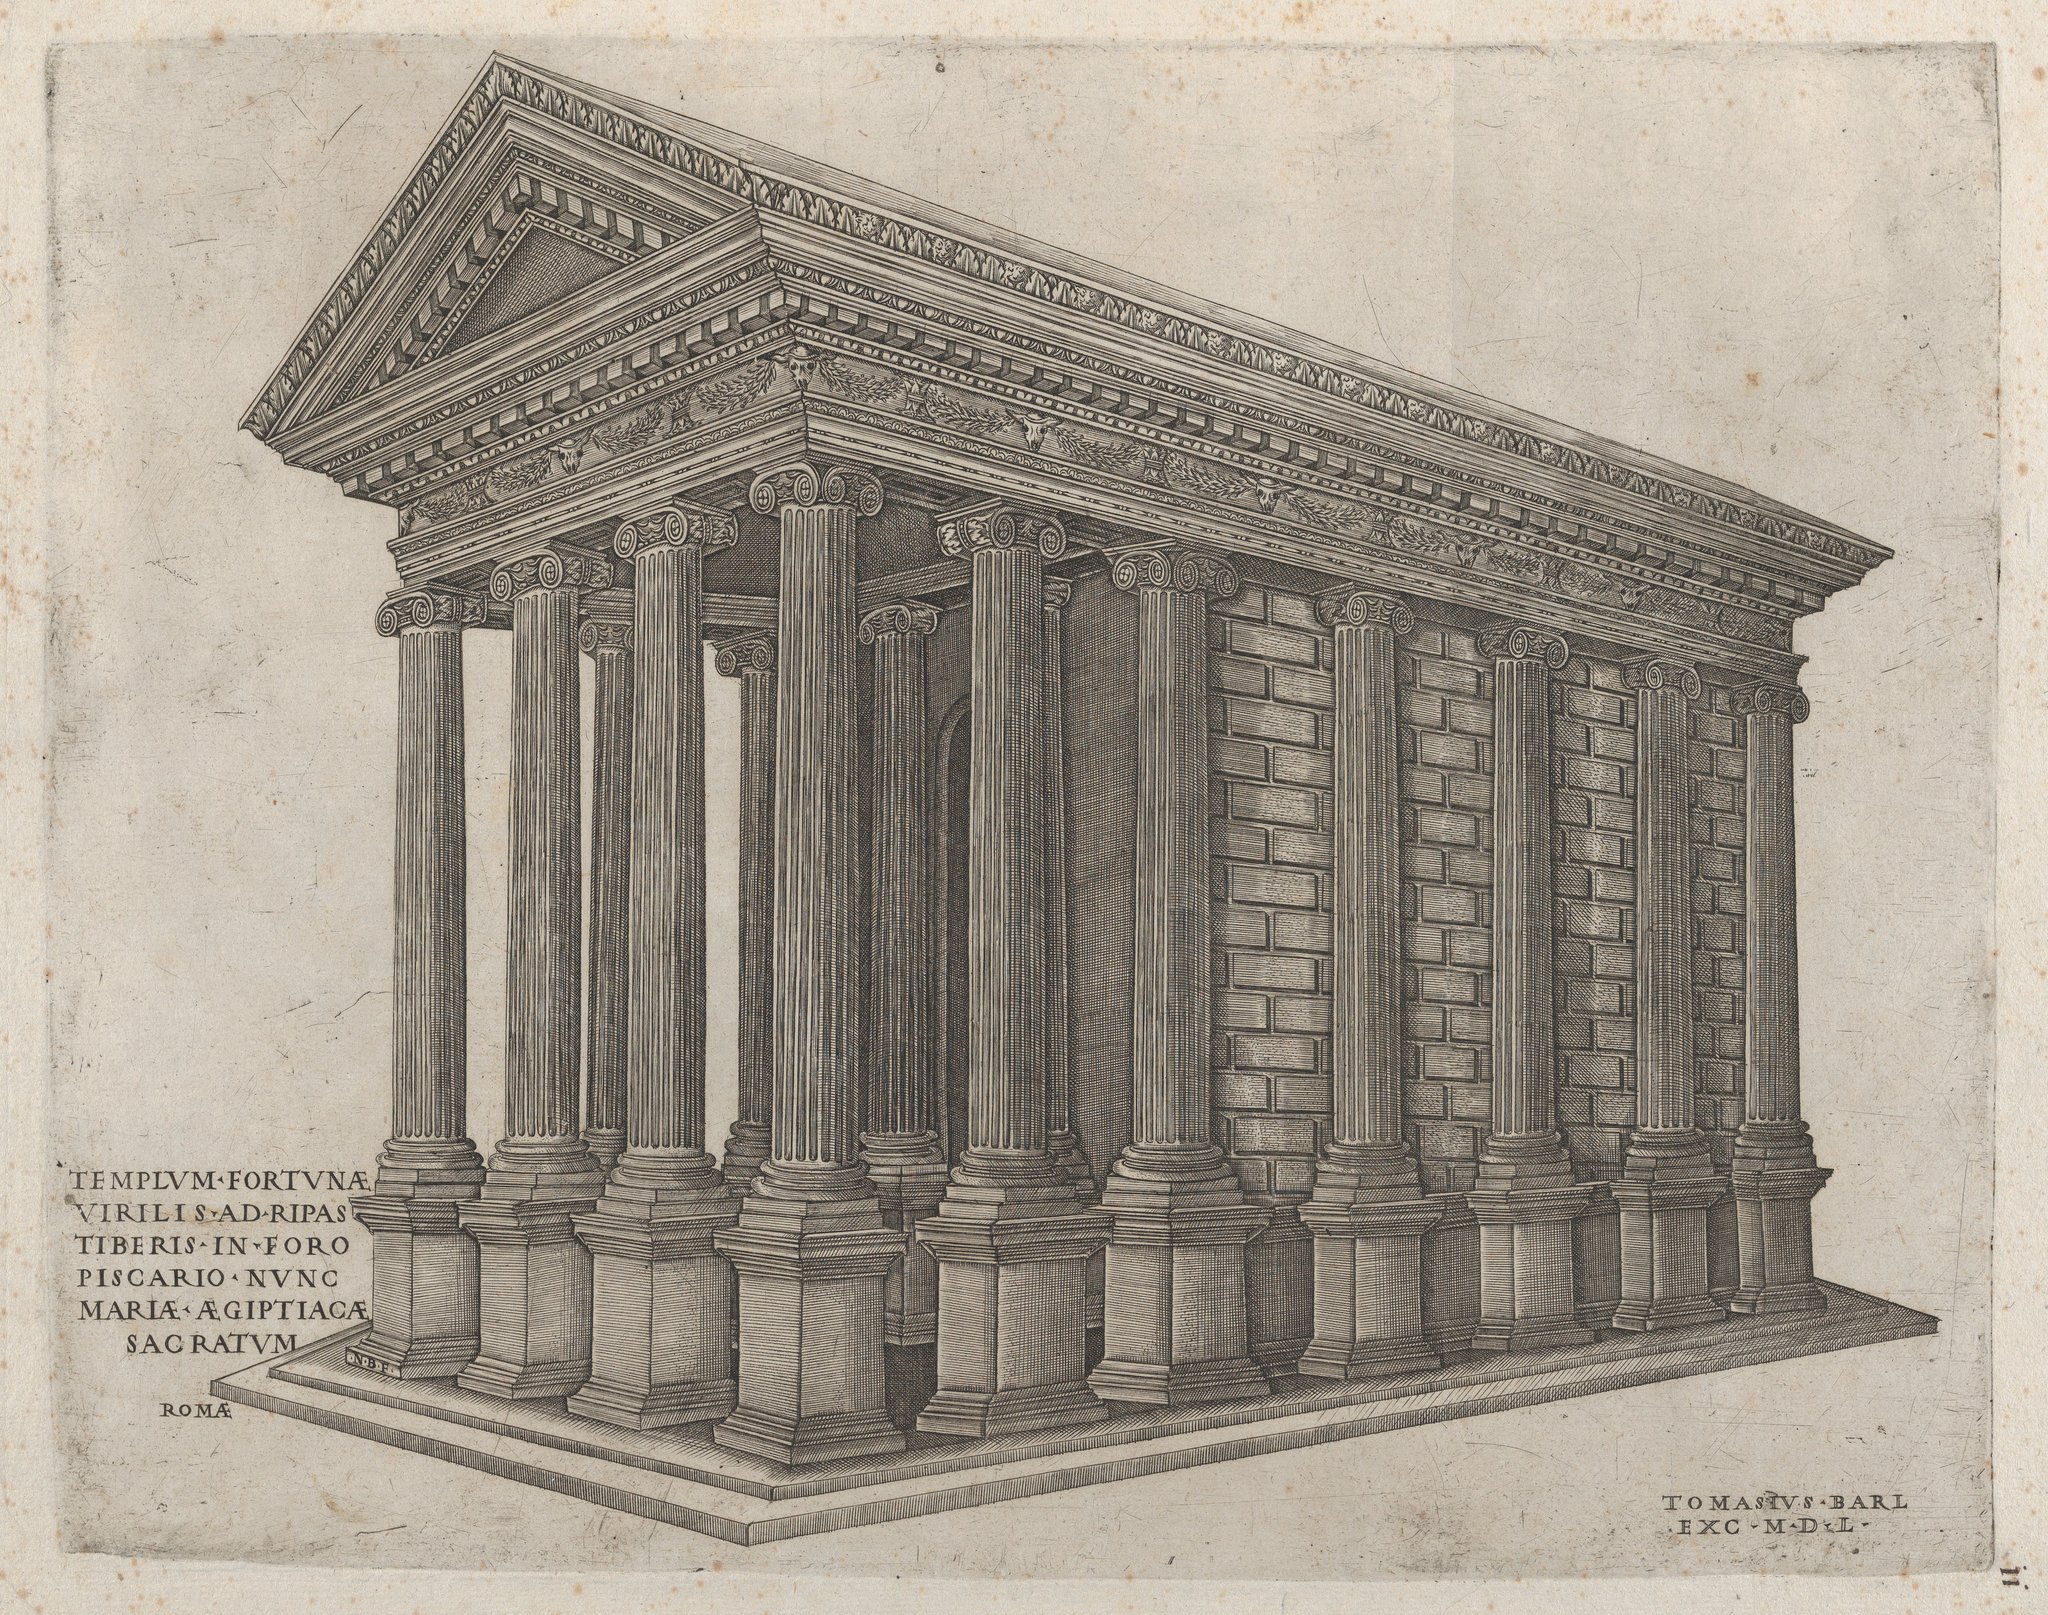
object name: print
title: The Temple of Fortune in Rome, from "Speculum Romanae Magnificentiae"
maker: nicolas beatrizet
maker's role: artist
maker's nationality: french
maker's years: 1515-1566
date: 1501-1600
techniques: engraving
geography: rome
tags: architecture,temples,rome